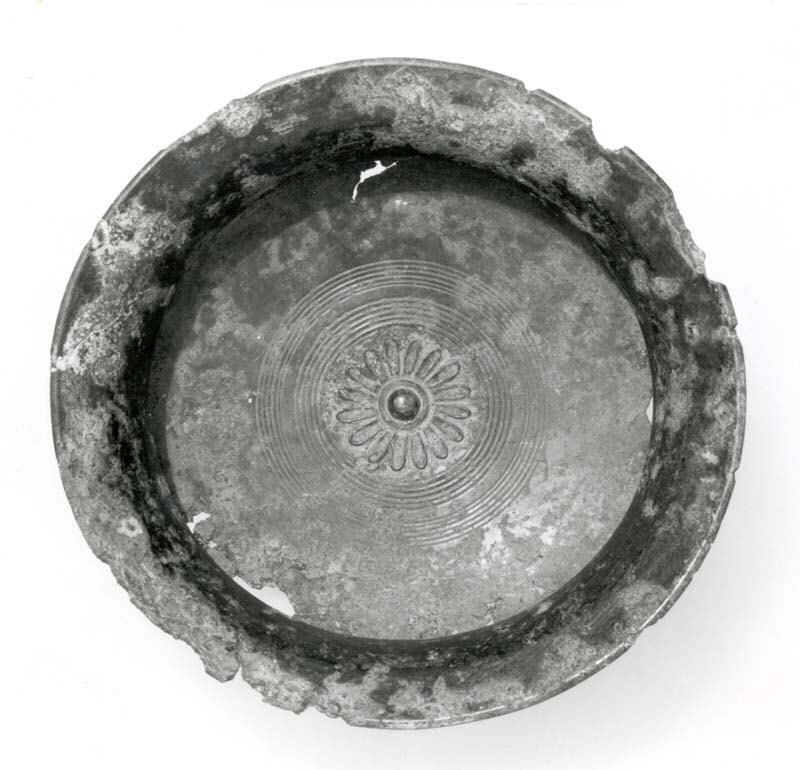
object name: bowl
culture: assyrian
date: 734-601 BCE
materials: bronze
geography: iran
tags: flowers